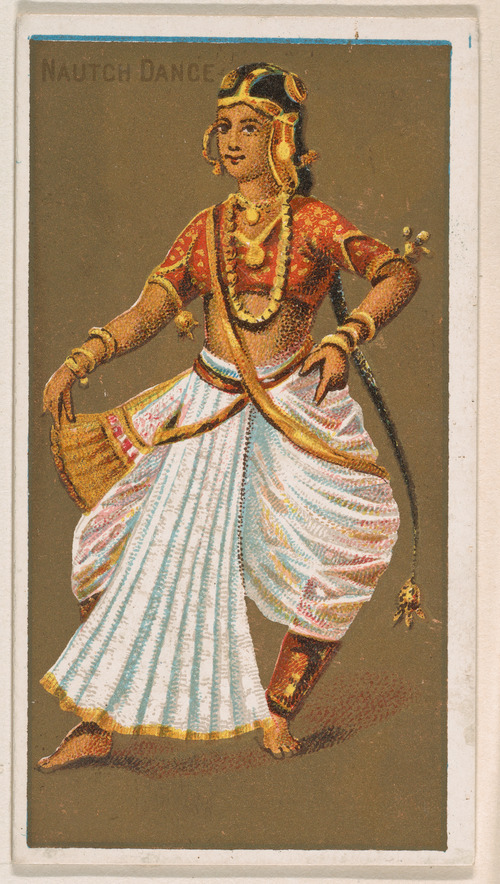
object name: print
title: Nautch-Dance, from National Dances (N225, Type 1) issued by Kinney Bros.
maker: kinney brothers tobacco company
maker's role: publisher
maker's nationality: american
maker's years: 1869-2011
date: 1889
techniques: color lithograph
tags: women,dancing,dancers